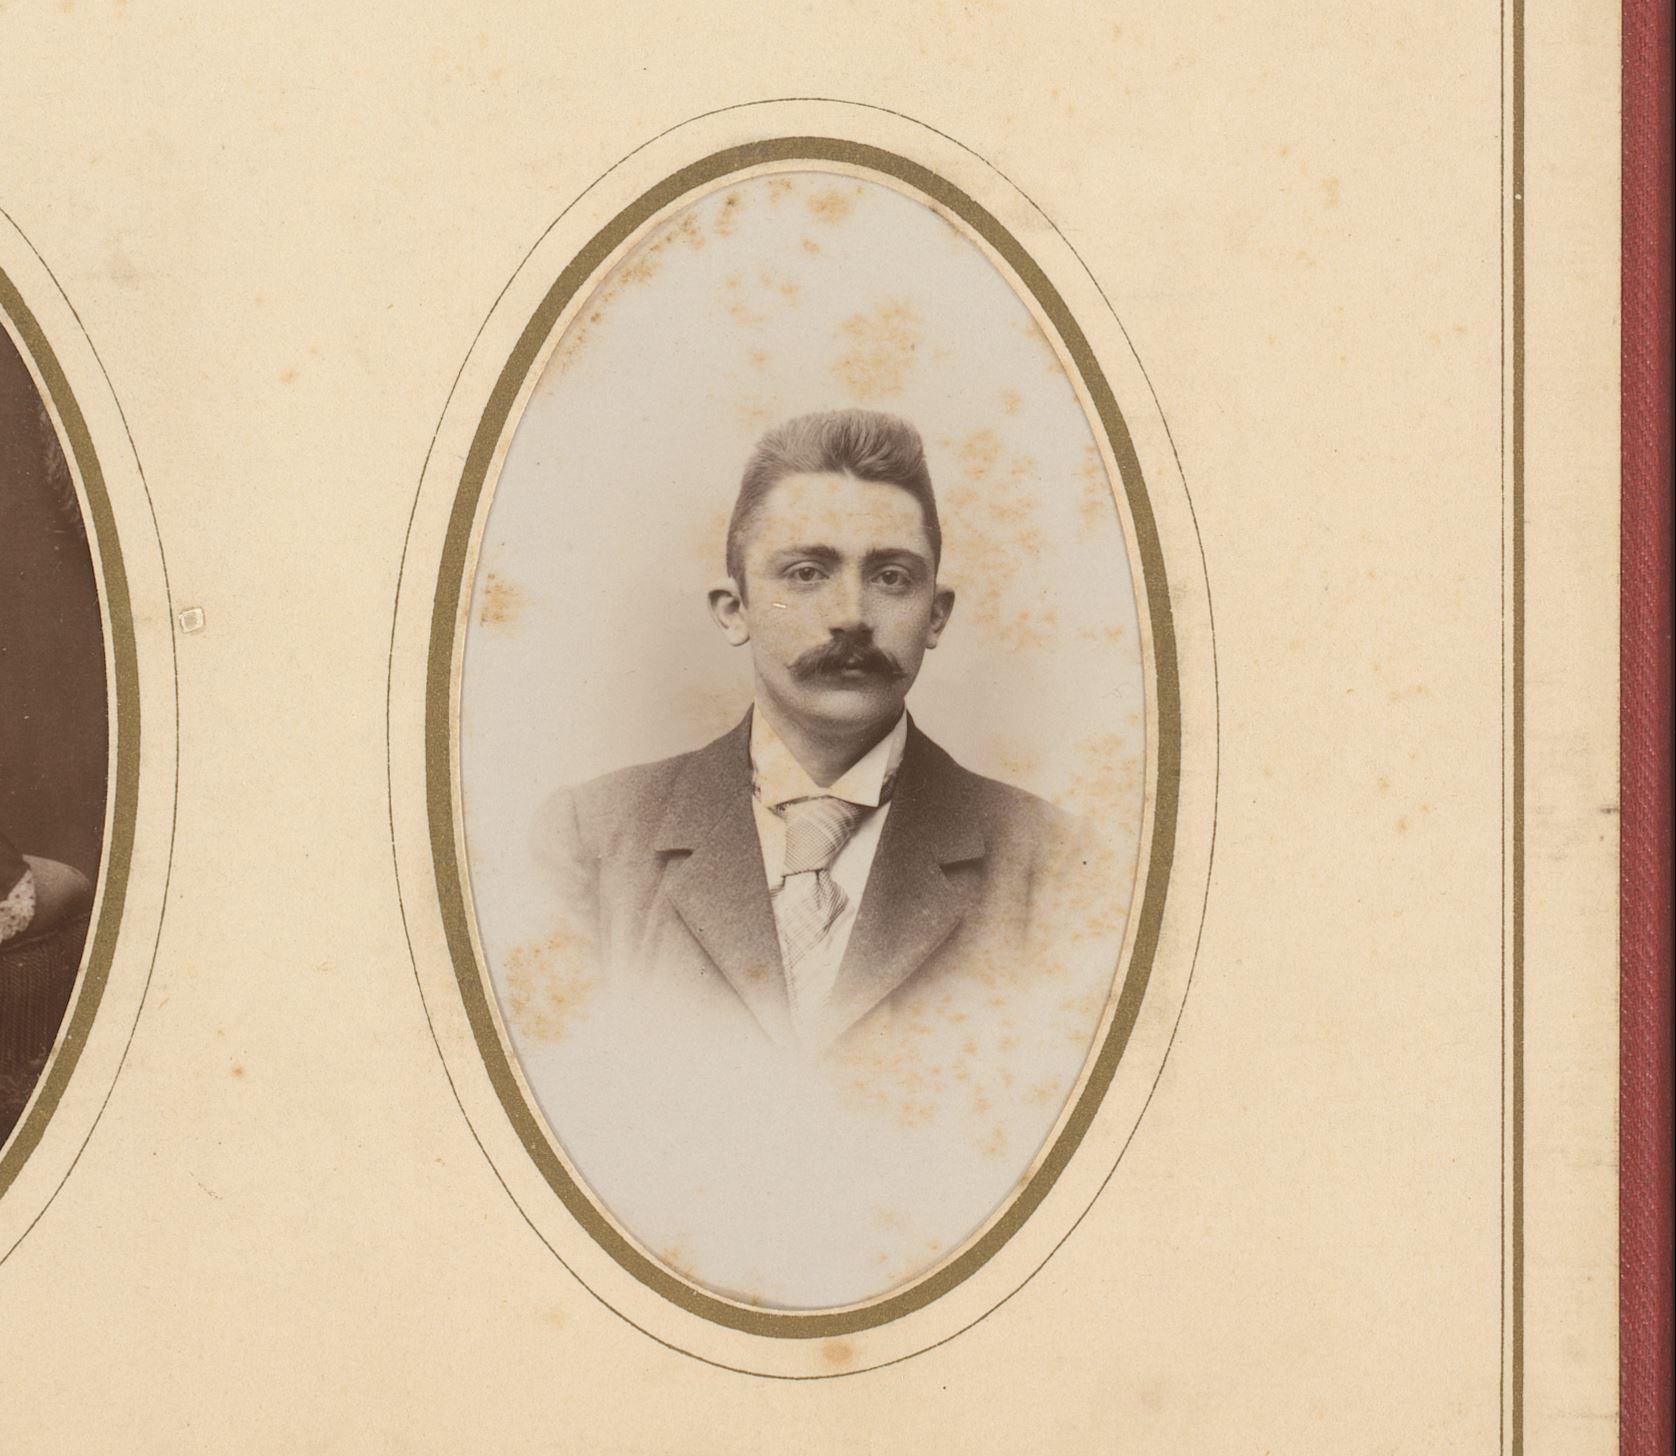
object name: photograph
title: Portret van een man met snor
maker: e. v.d. kerkhoff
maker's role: fotograaf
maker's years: 1861-1943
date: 1887-1900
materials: cardboard, photographic support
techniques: albumen print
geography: arnhem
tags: moustache, historical persons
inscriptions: inscription: ‘Atelier/ E. v.d. Kerkhoff/ Arnhem/ Ridderstraat No. 27.’